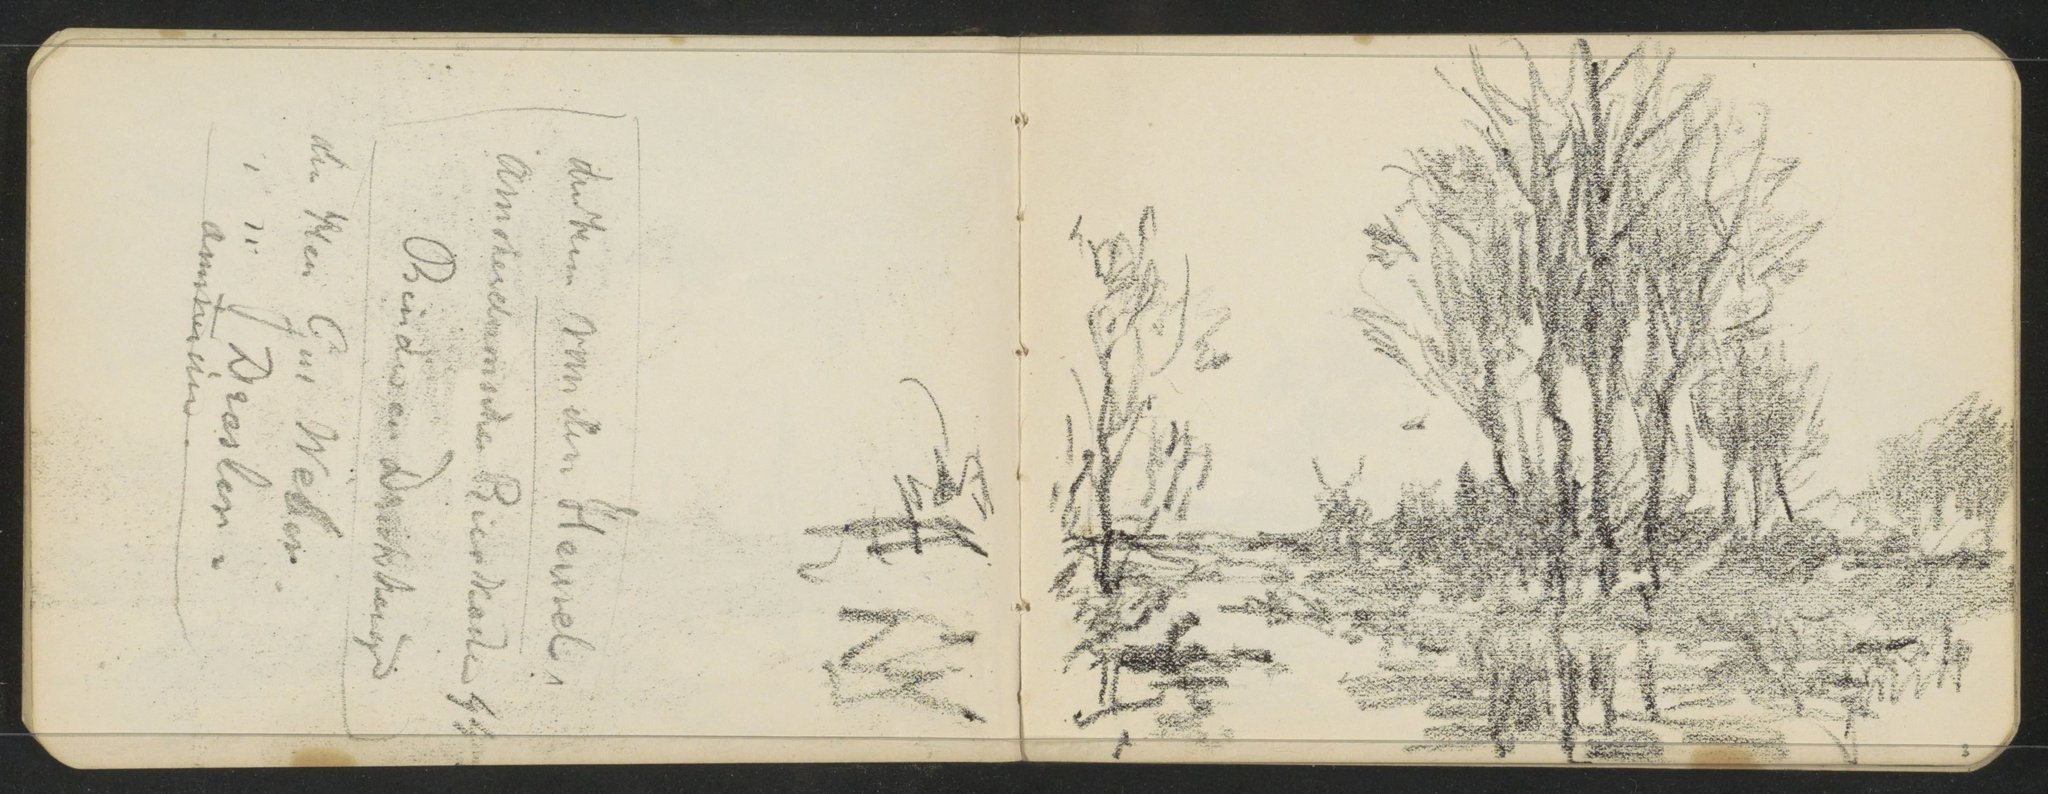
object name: sketchbook leaf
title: Bomen aan een waterkant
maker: willem cornelis rip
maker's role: draughtsman, painter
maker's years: 1856-1922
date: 1914-1916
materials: chalk, paper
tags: landscapes with waters, waterscapes, seascapes (in the temperate zone), windmill in landscape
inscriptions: address: ‘den Heer van der Heuvel/ Amsterdamsche Bierkade 44/ Bind en Drukhuys/ Den Heer Gui Weber/ ' '' Dr[...]/ Amsterdam’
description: Op de achtergrond een molen. Blad 2 verso en 3 recto uit een schetsboek met 41 bladen.